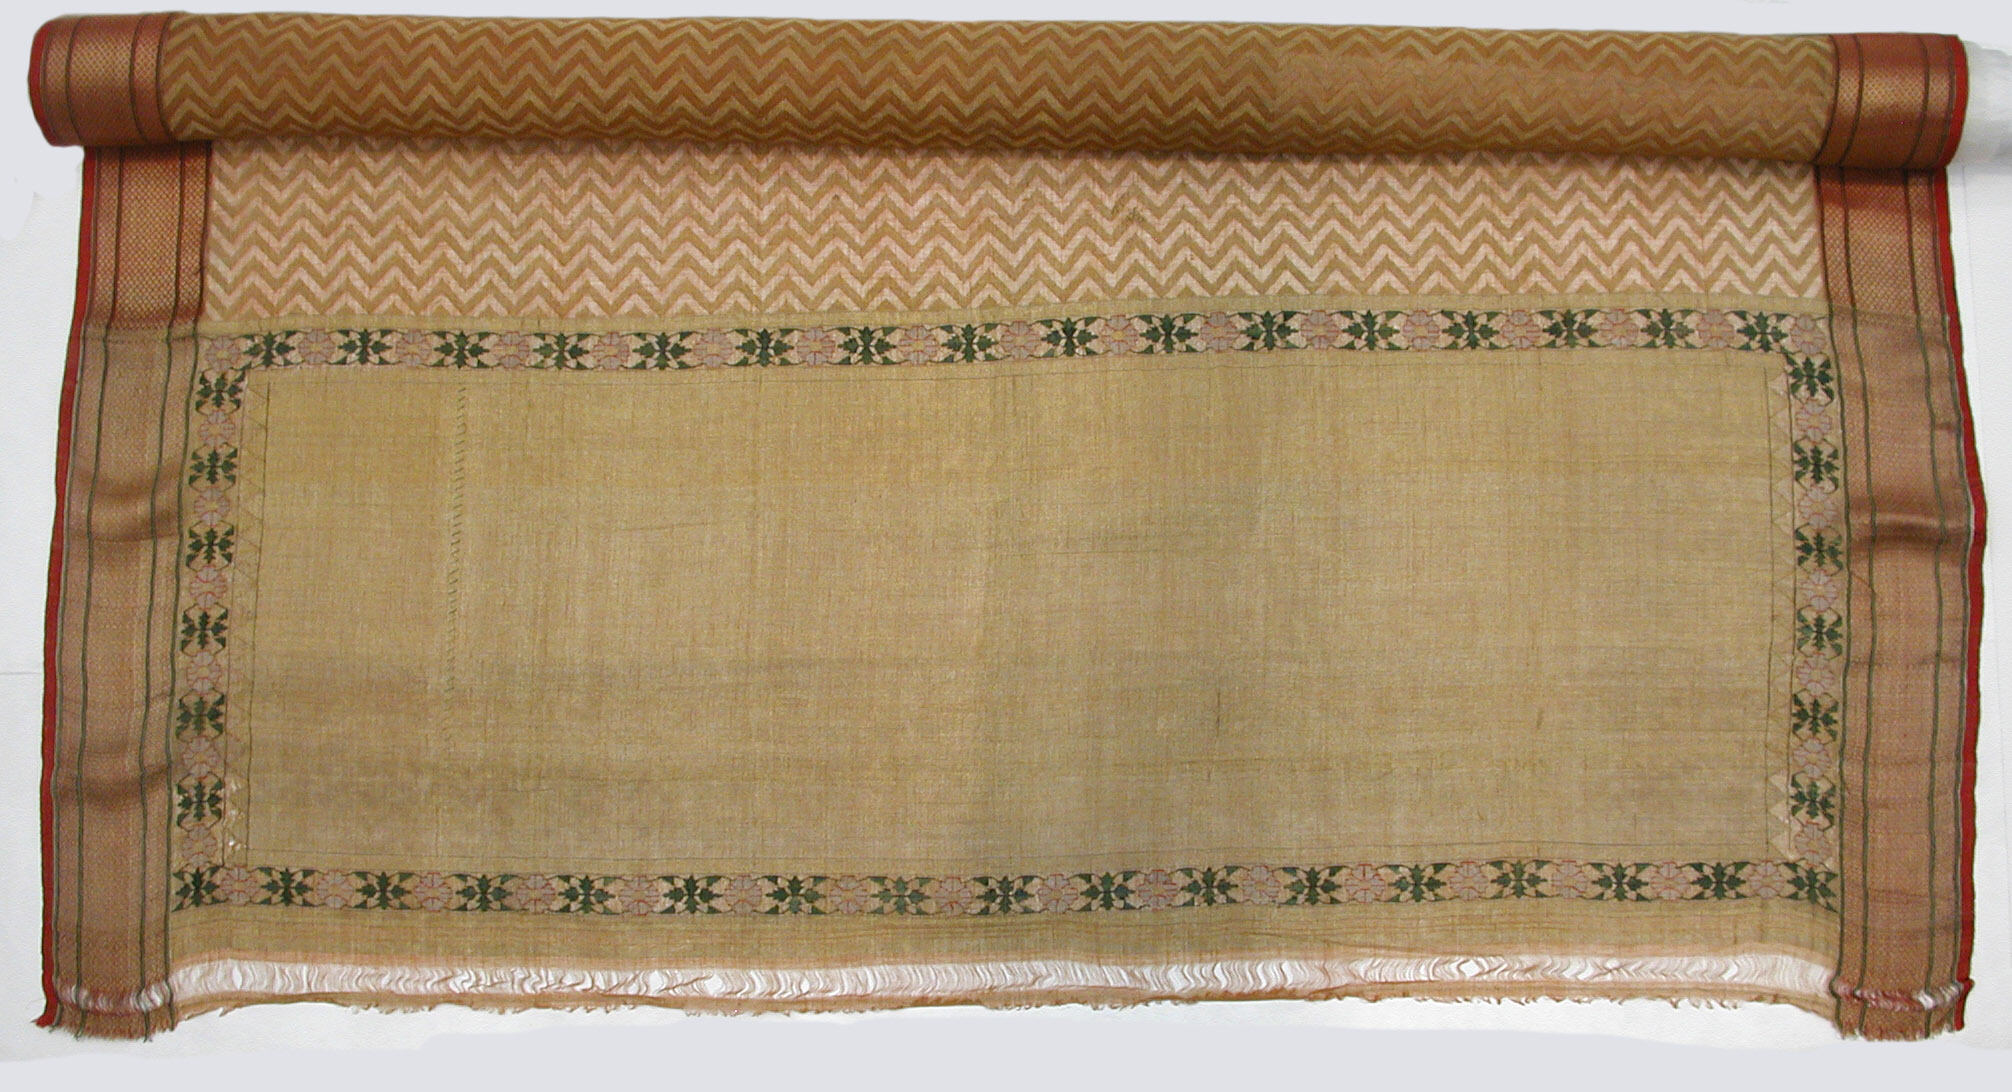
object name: sari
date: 1701-1800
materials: metal thread, silk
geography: india